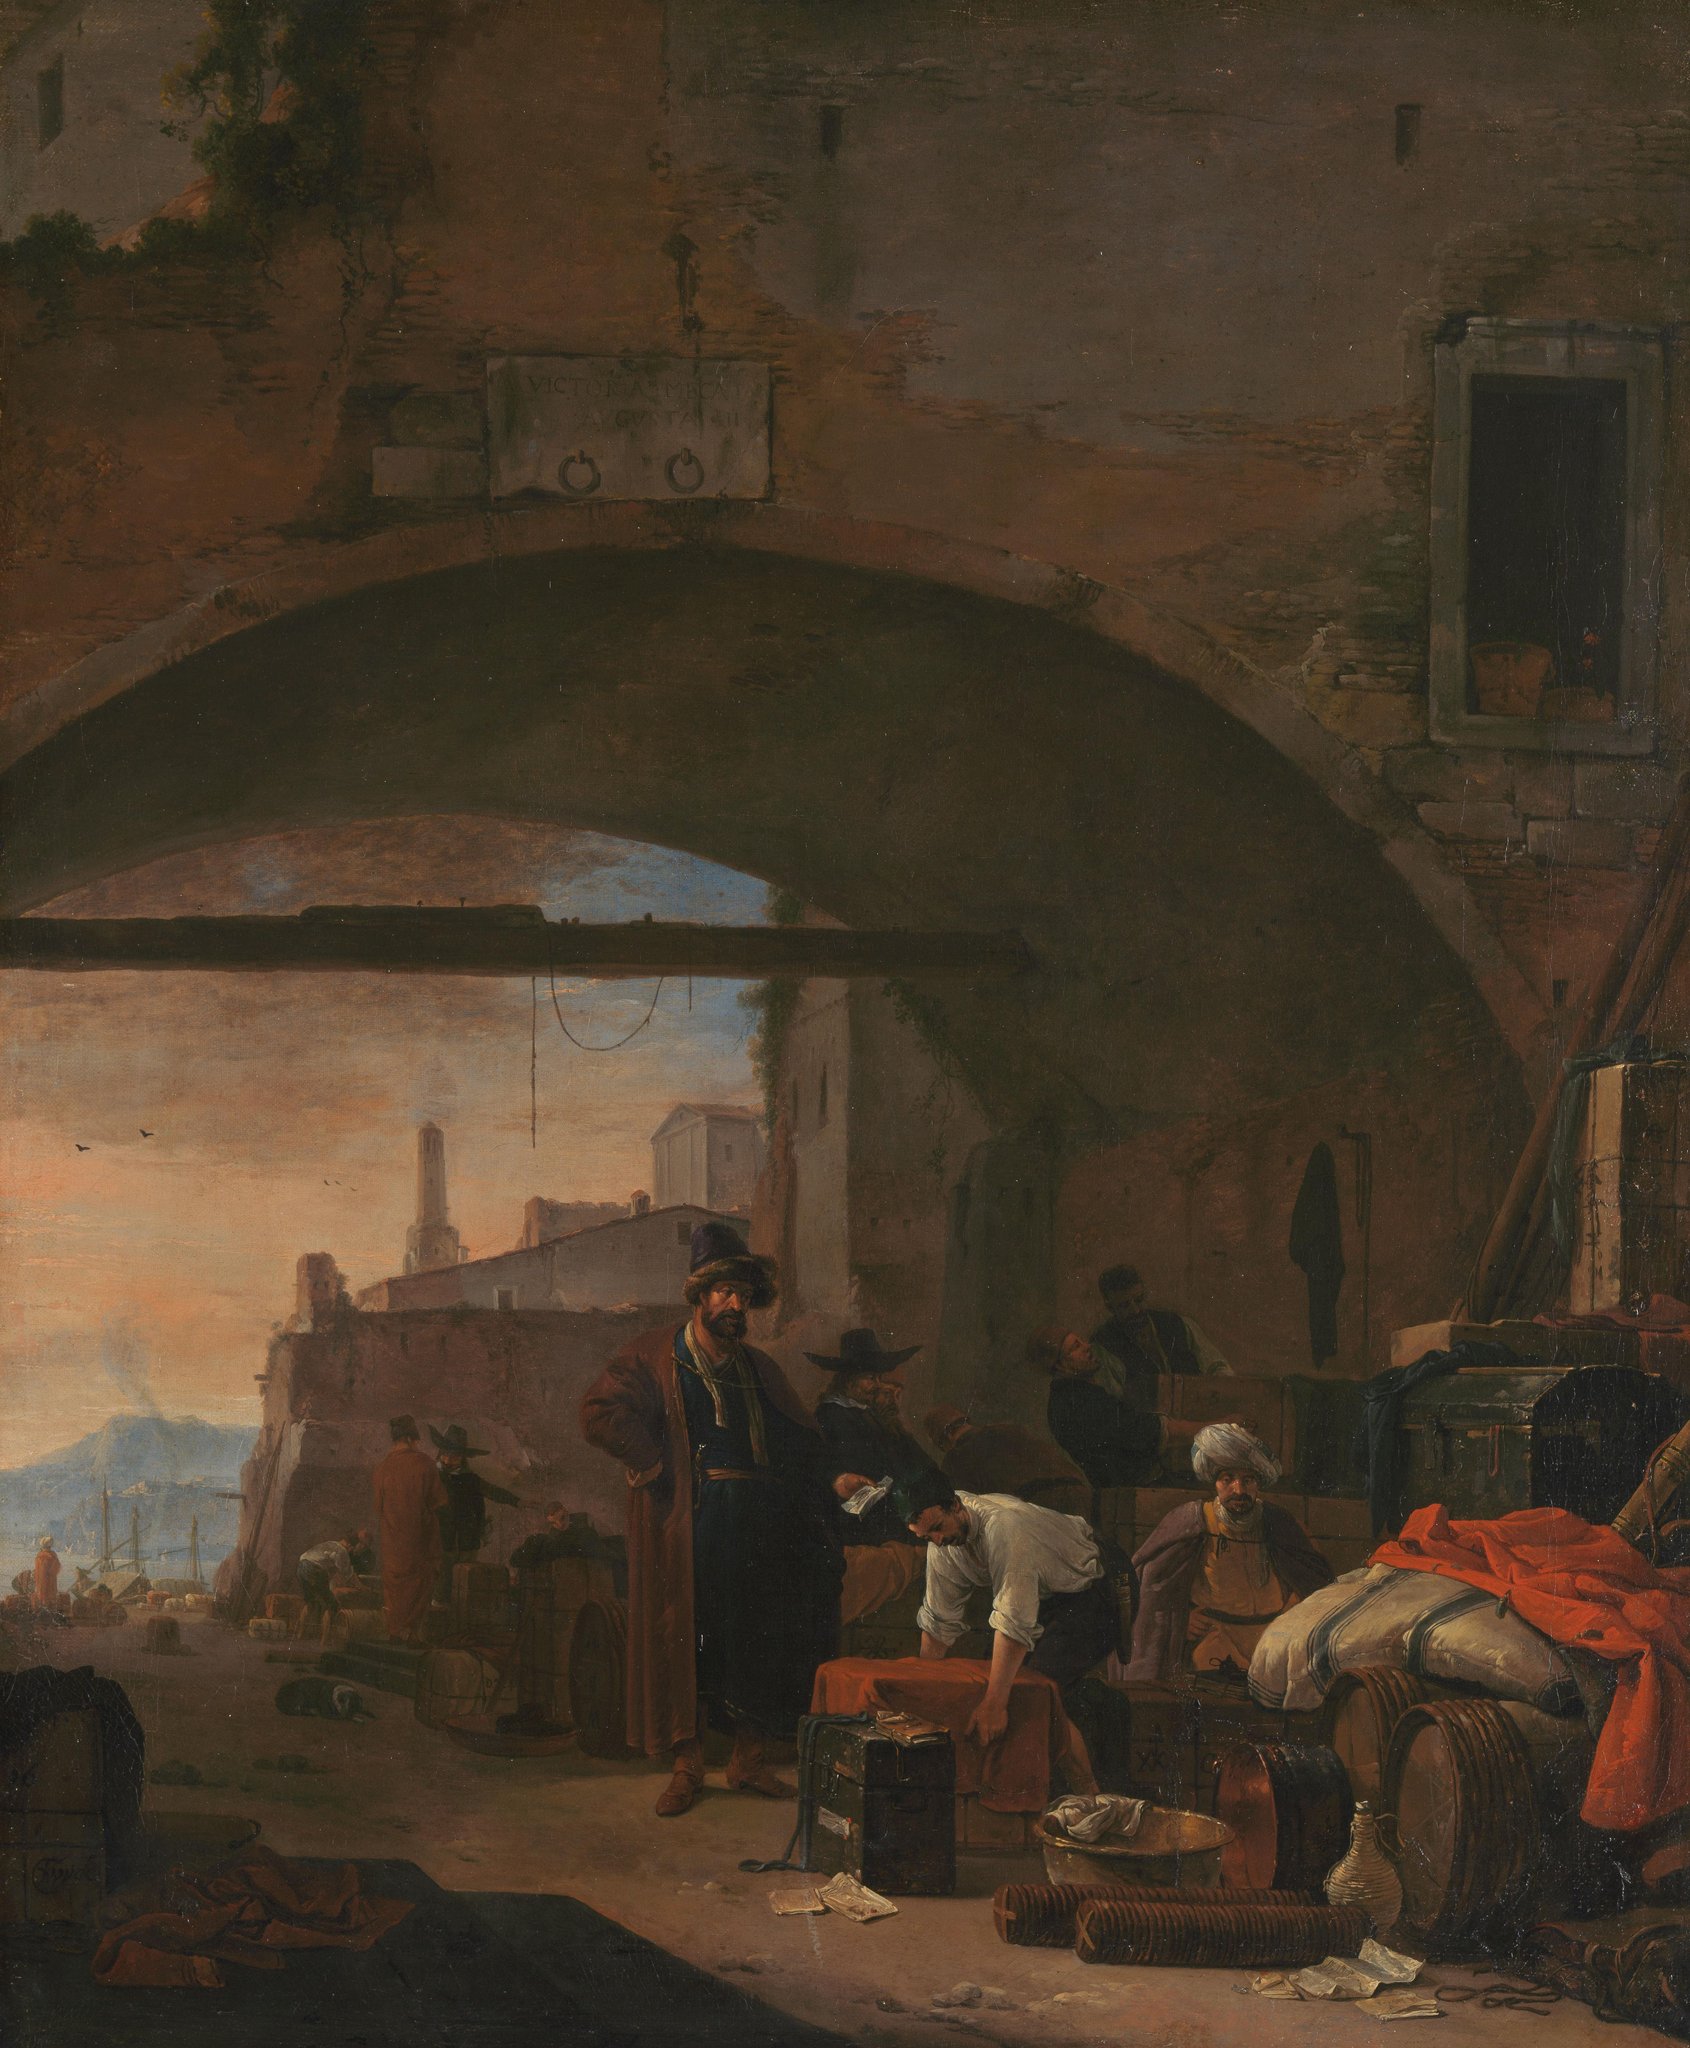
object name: painting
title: A Levantine Harbour City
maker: thomas wijck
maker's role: draughtsman, painter, print maker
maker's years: 1616-1677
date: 1660-1670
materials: canvas, oil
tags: harbour, warehouse (~ harbour), pier, quay, wharf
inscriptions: signature, lower left, on a crate (T and w ligated): ‘Twijck’, inscription, upper left, on the stone tablet above the arch: ‘VICTORIA MECATAS / AUGUSTA II’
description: Levantijnse haven. Oosterse kooplieden onder een boog op de kade van een haven waar kisten, koffers, tonnen en andere goederen voor transport gereed worden gemaakt.